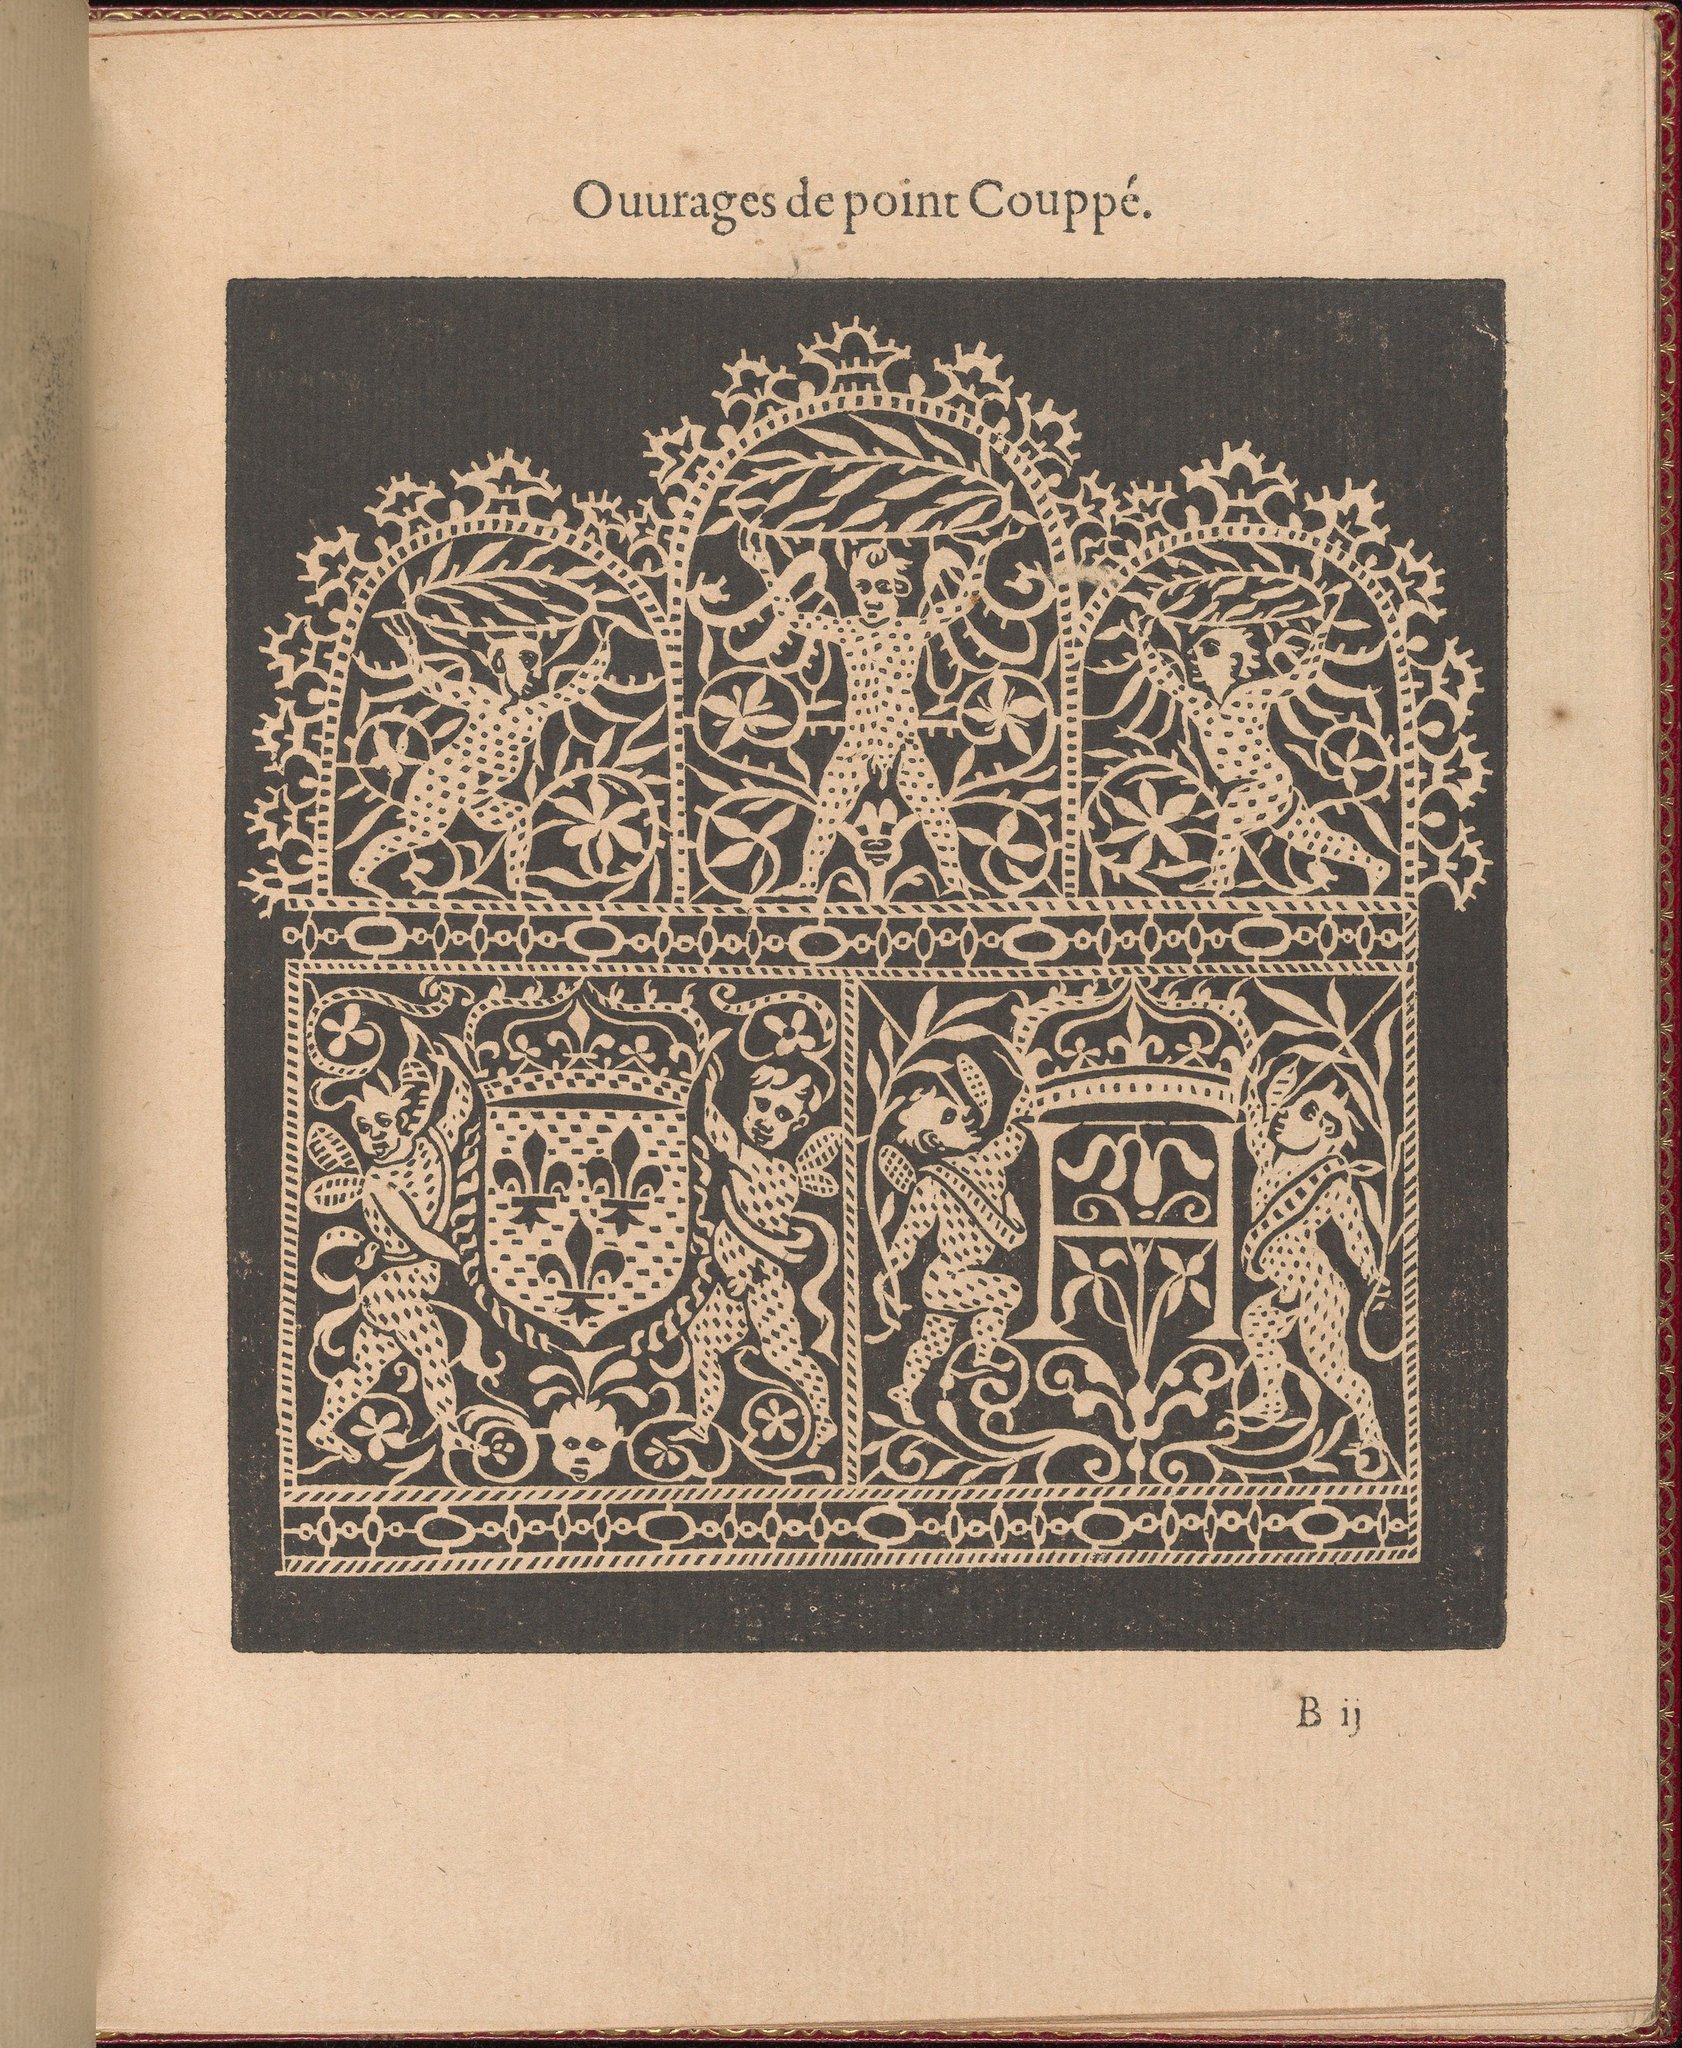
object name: book print ornament architecture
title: Les Singuliers et Nouveaux Portraicts... page 6 (recto)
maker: federico de vinciolo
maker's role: designer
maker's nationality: italian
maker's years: 1582-1599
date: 1588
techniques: woodcut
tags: ornament,putti,coat of arms